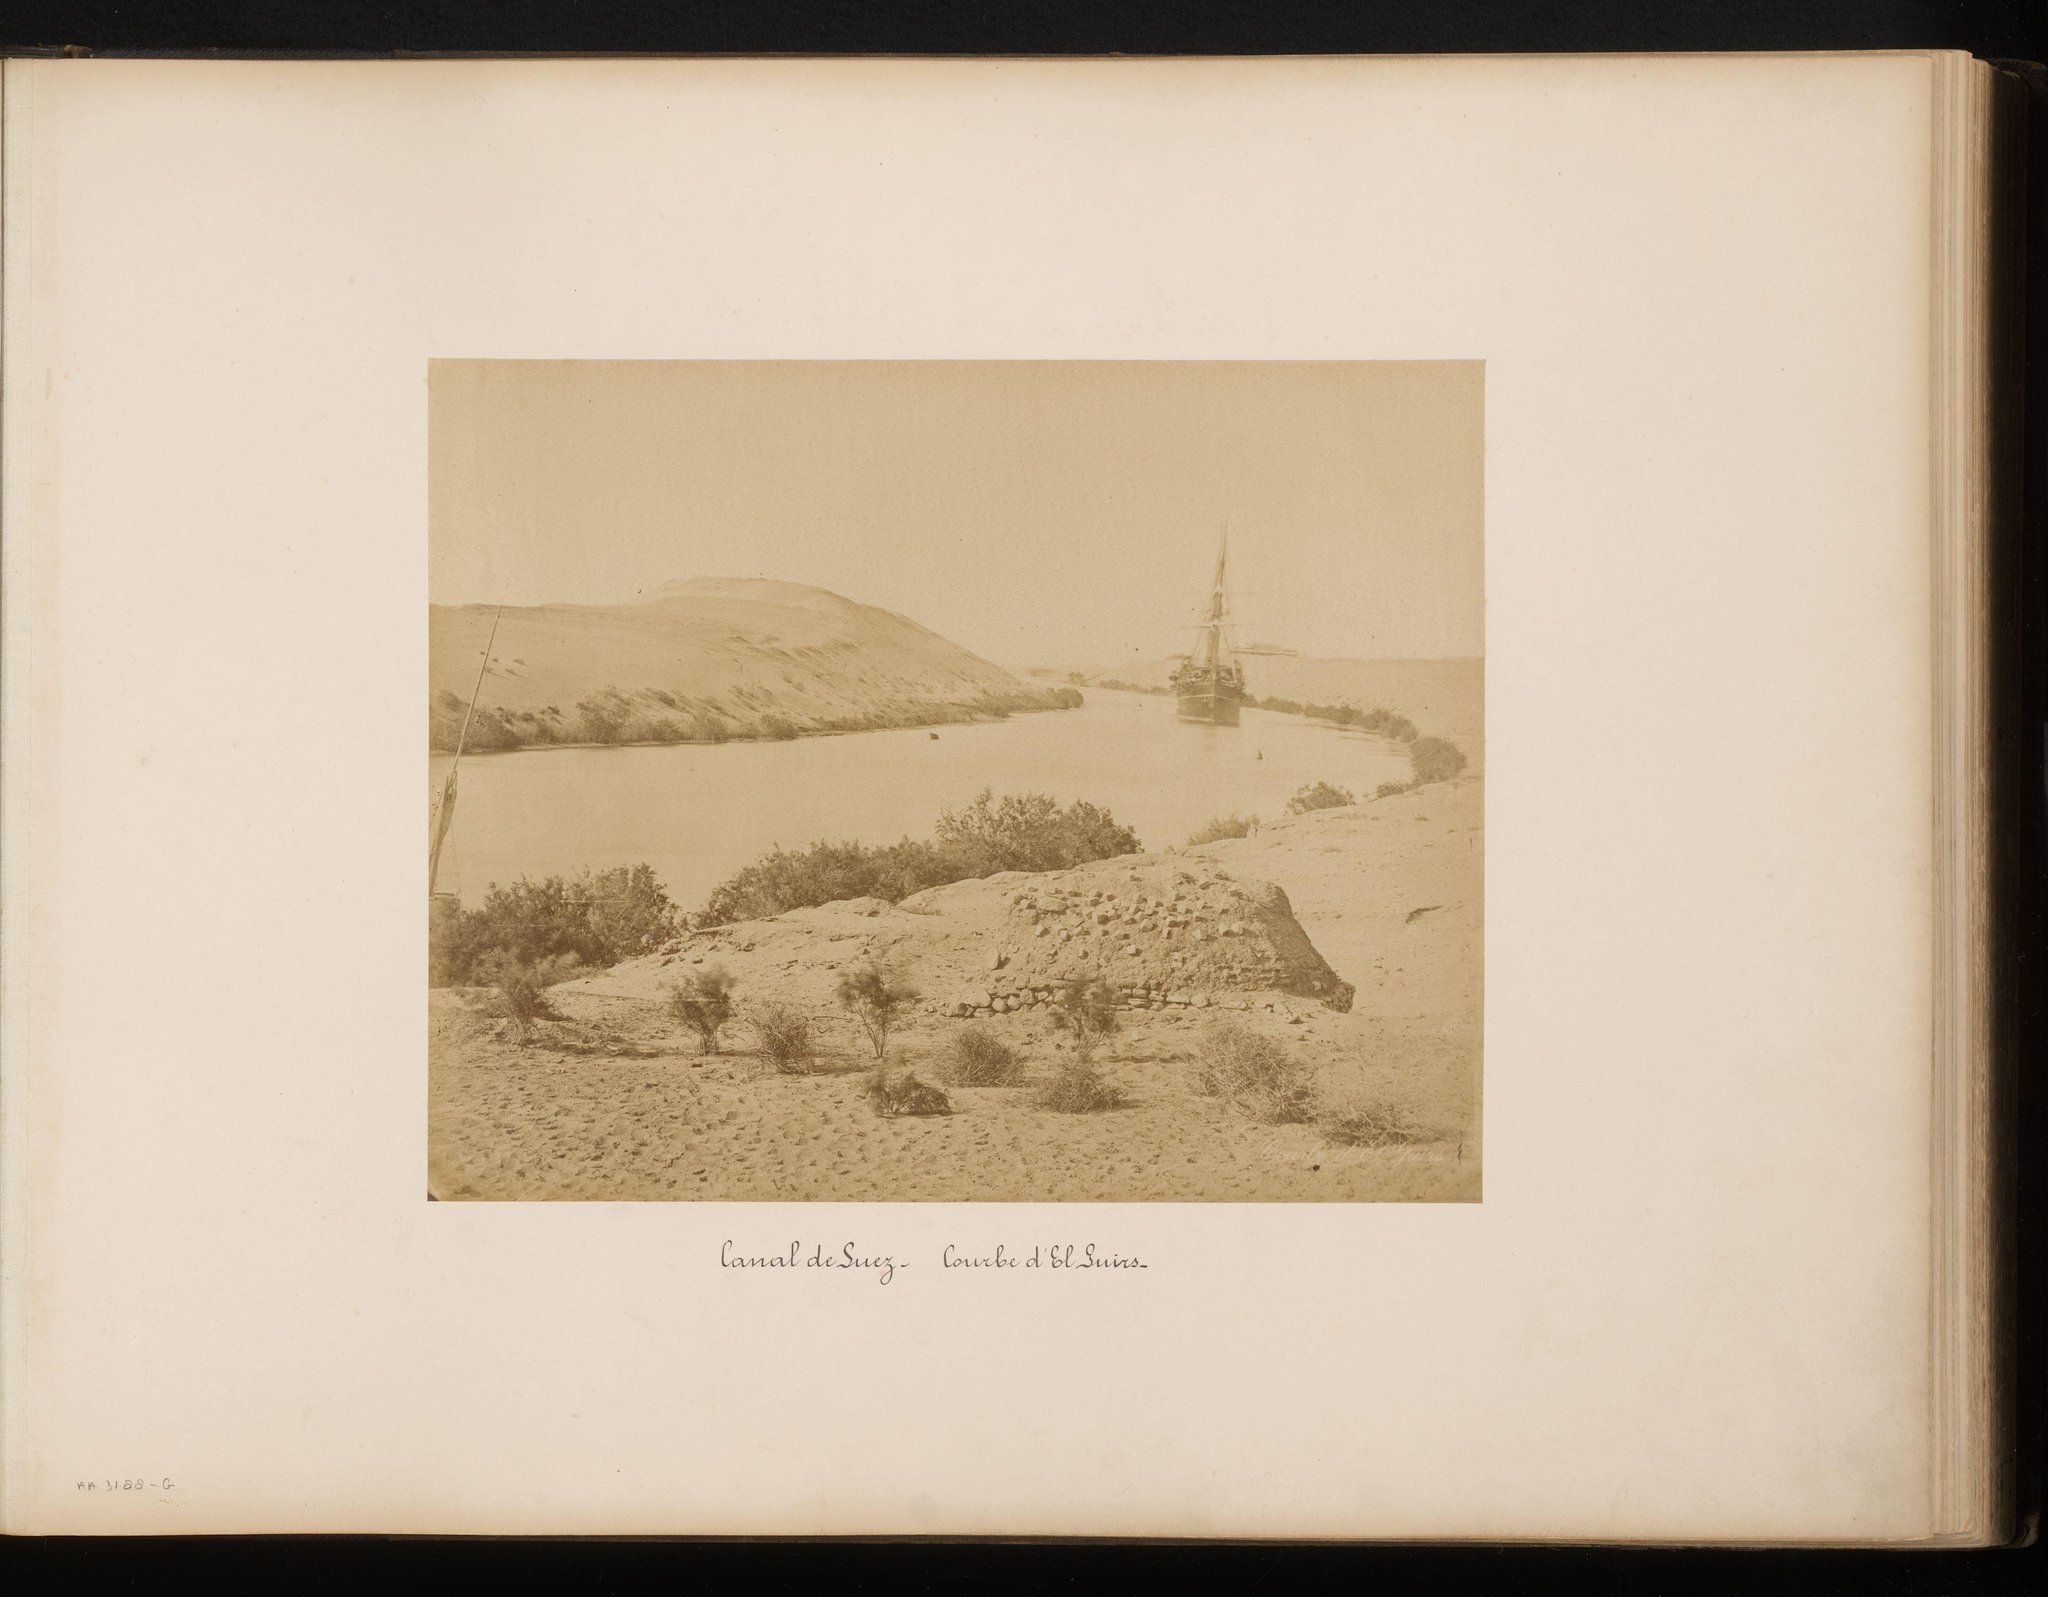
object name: photograph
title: Schip op het Suezkanaal in de bocht van El Guirs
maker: Anonymous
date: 1880-1883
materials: photographic support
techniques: albumen print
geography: suez canal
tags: canal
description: Onderdeel van Reisalbum met opnames van bezienswaardigheden in Egypte, Nederlands-Indië, Singapore en Ceylon.